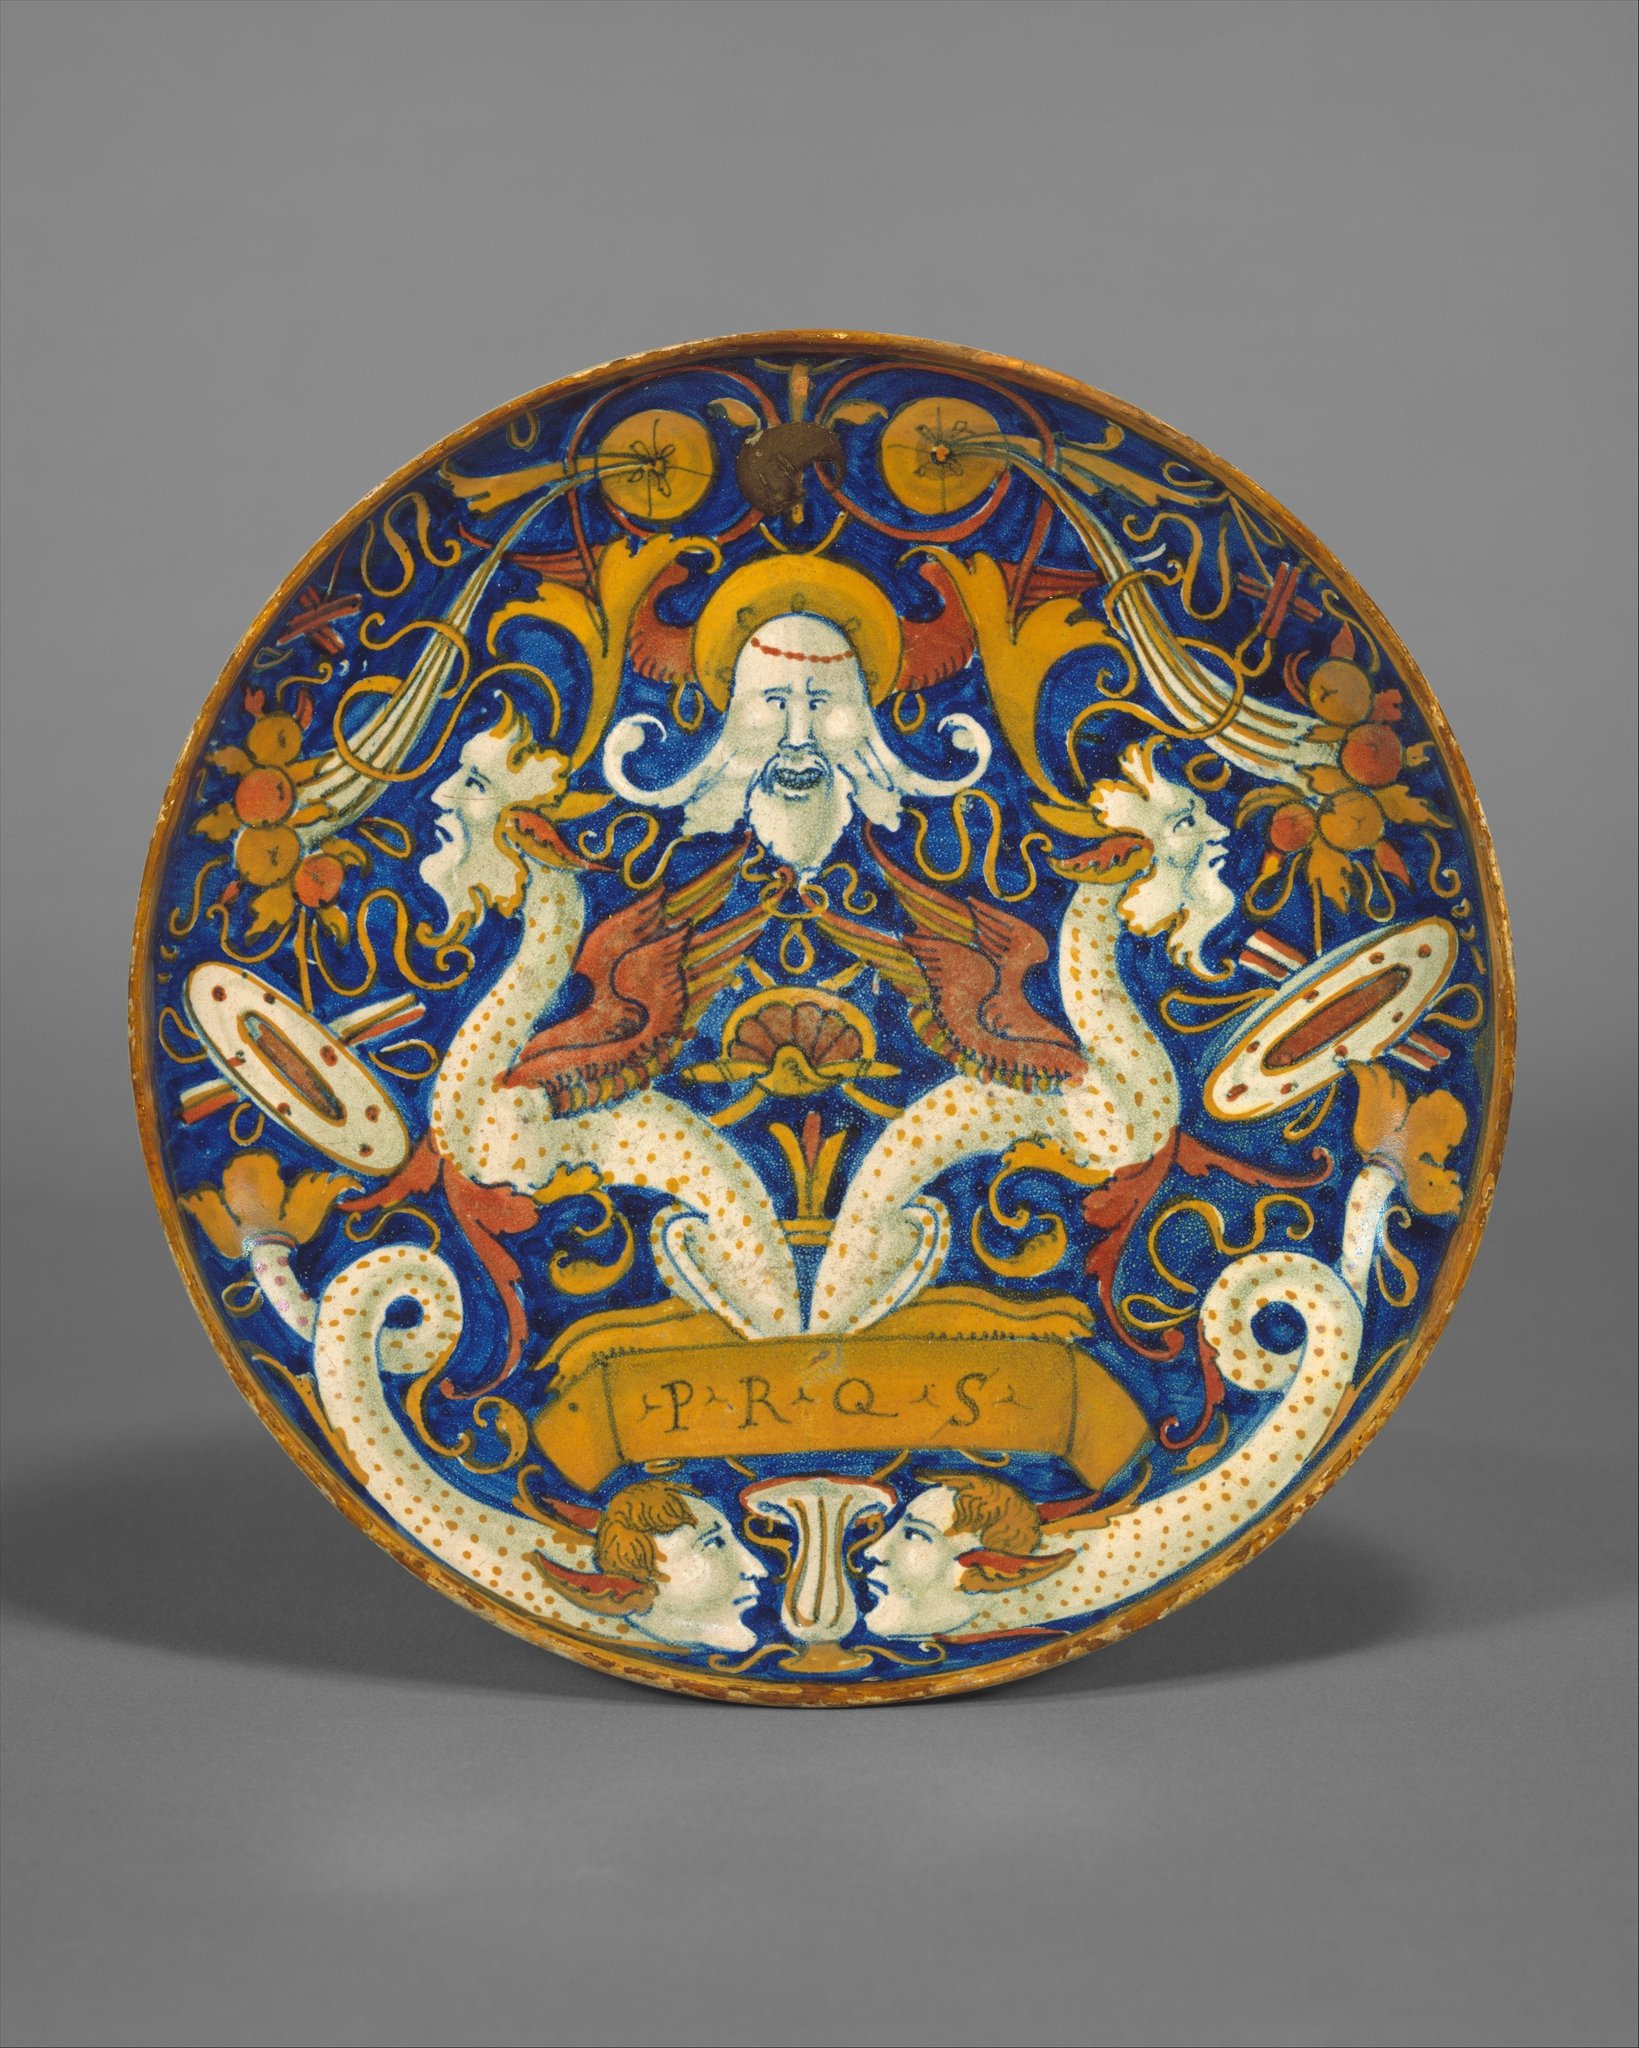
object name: dish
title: Dish (coppa)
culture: italian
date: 1530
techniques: maiolica, glazing